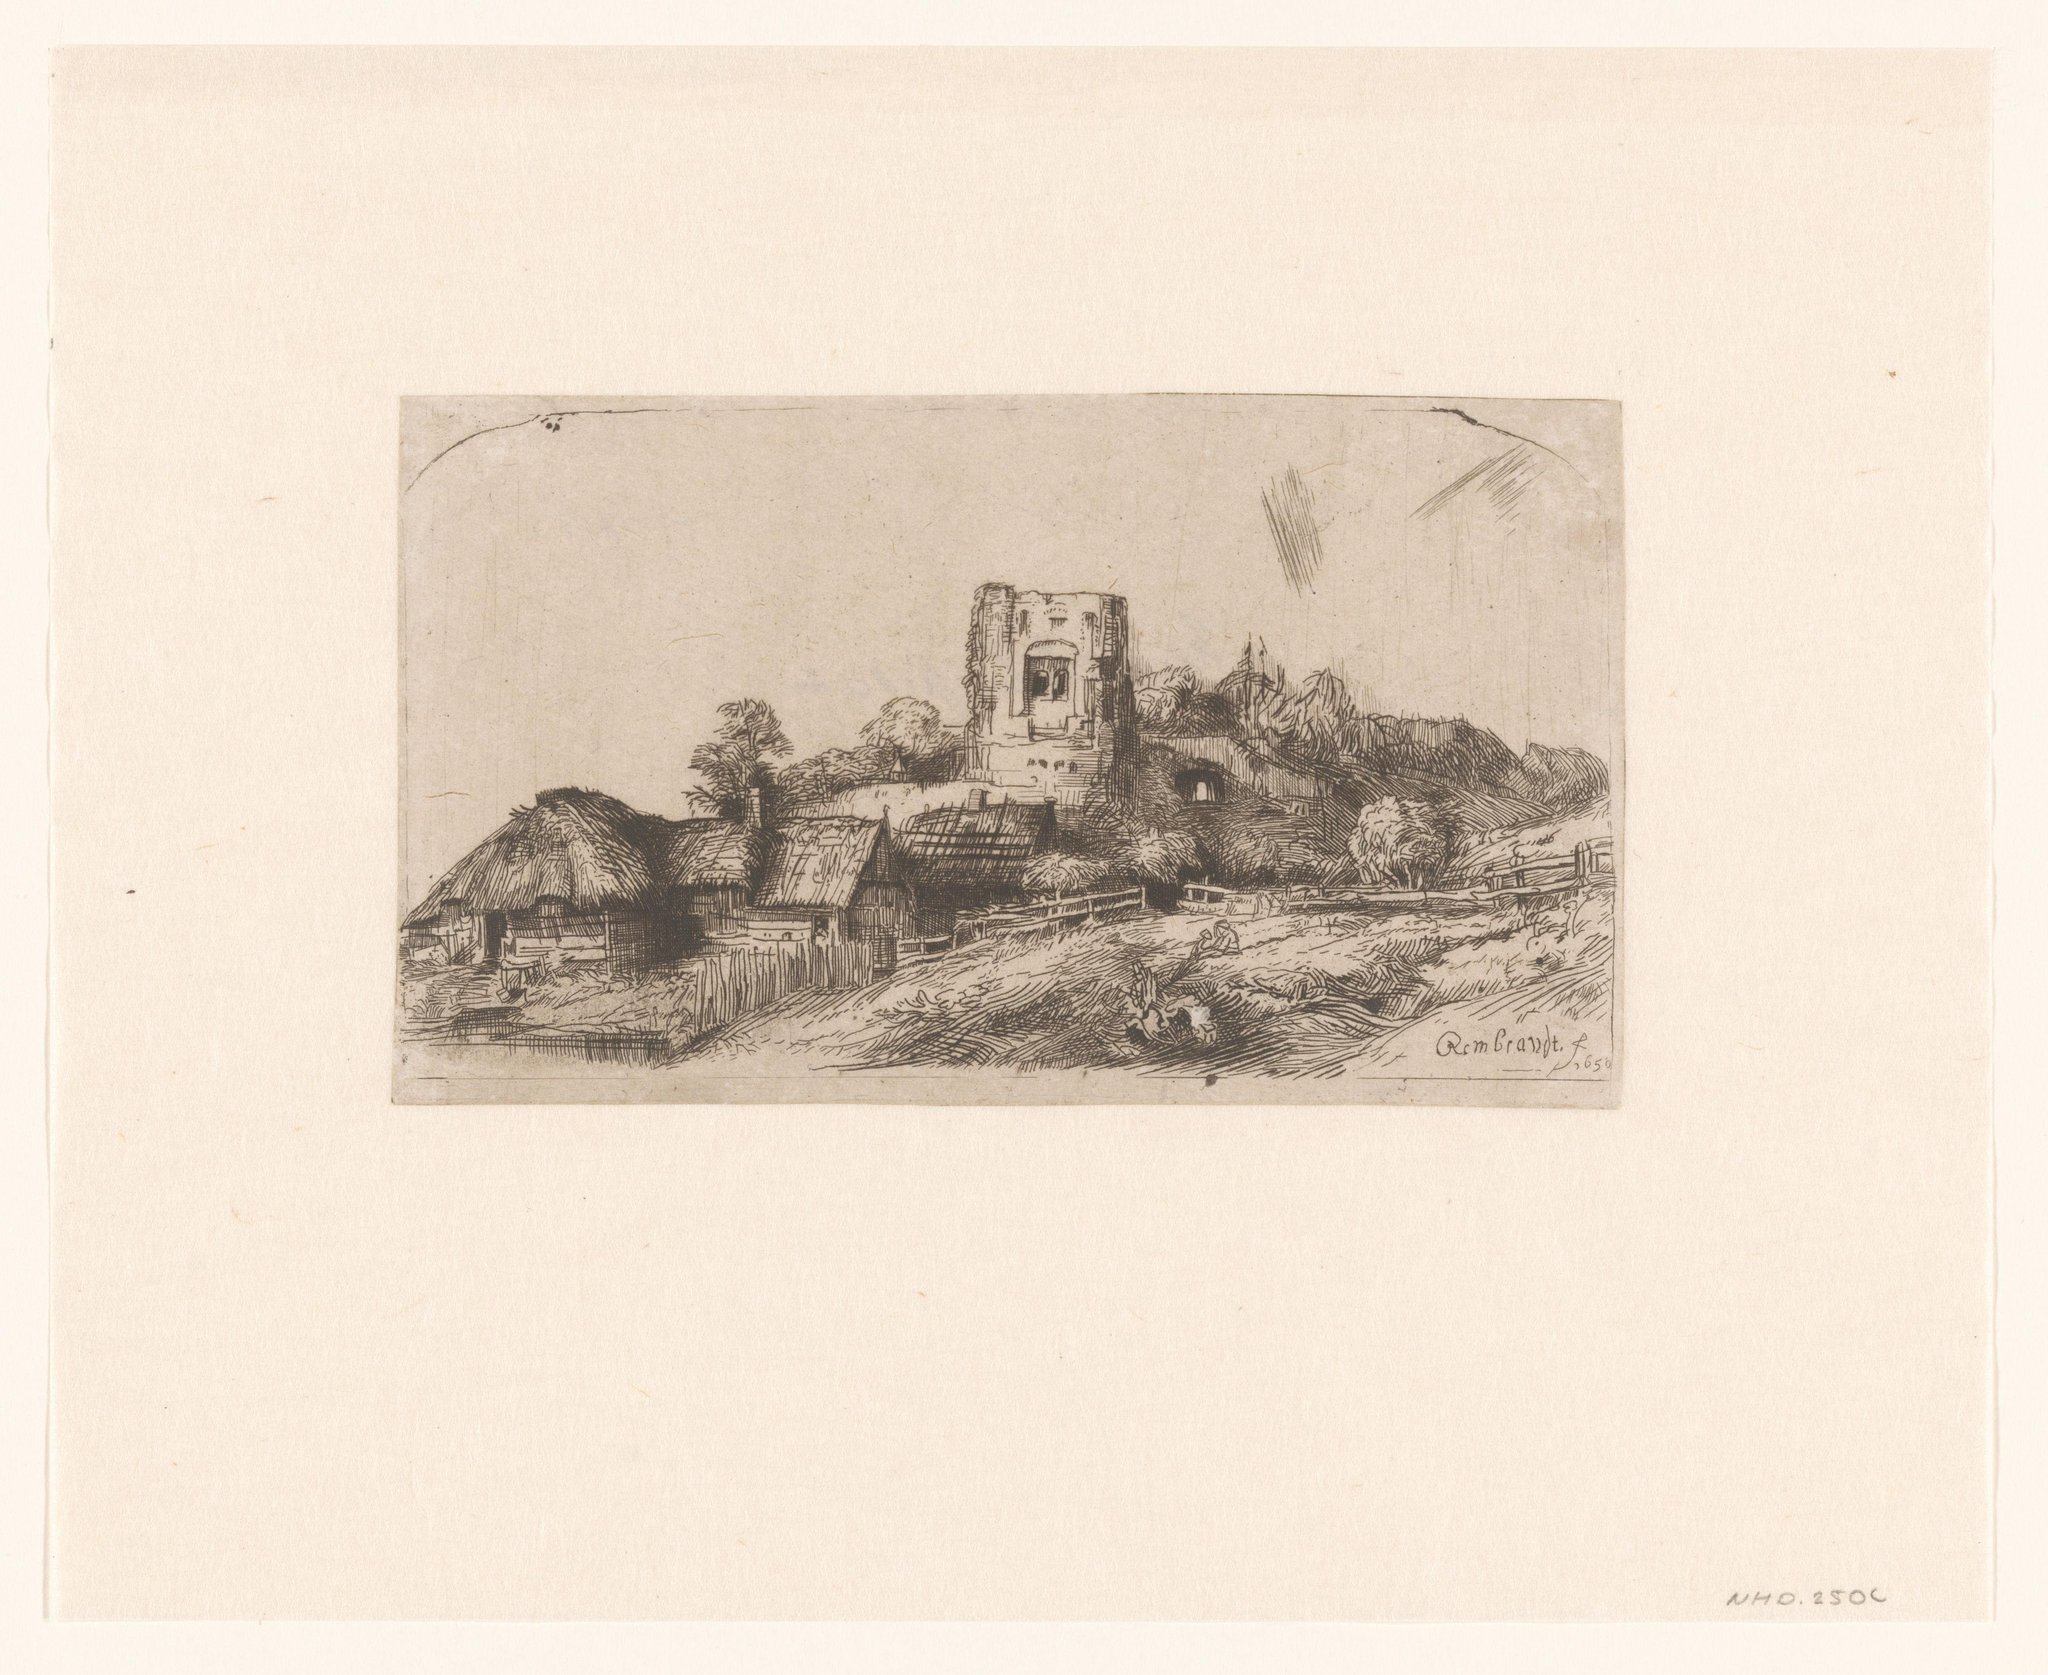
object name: print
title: Landscape with a square tower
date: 1841-1911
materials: paper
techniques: etching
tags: city-view, and landscape with man-made constructions, hut, cabin, lodge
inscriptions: collector's mark: Lugt 2760, collector's mark: Lugt 4071, collector's mark: Lugt 2228